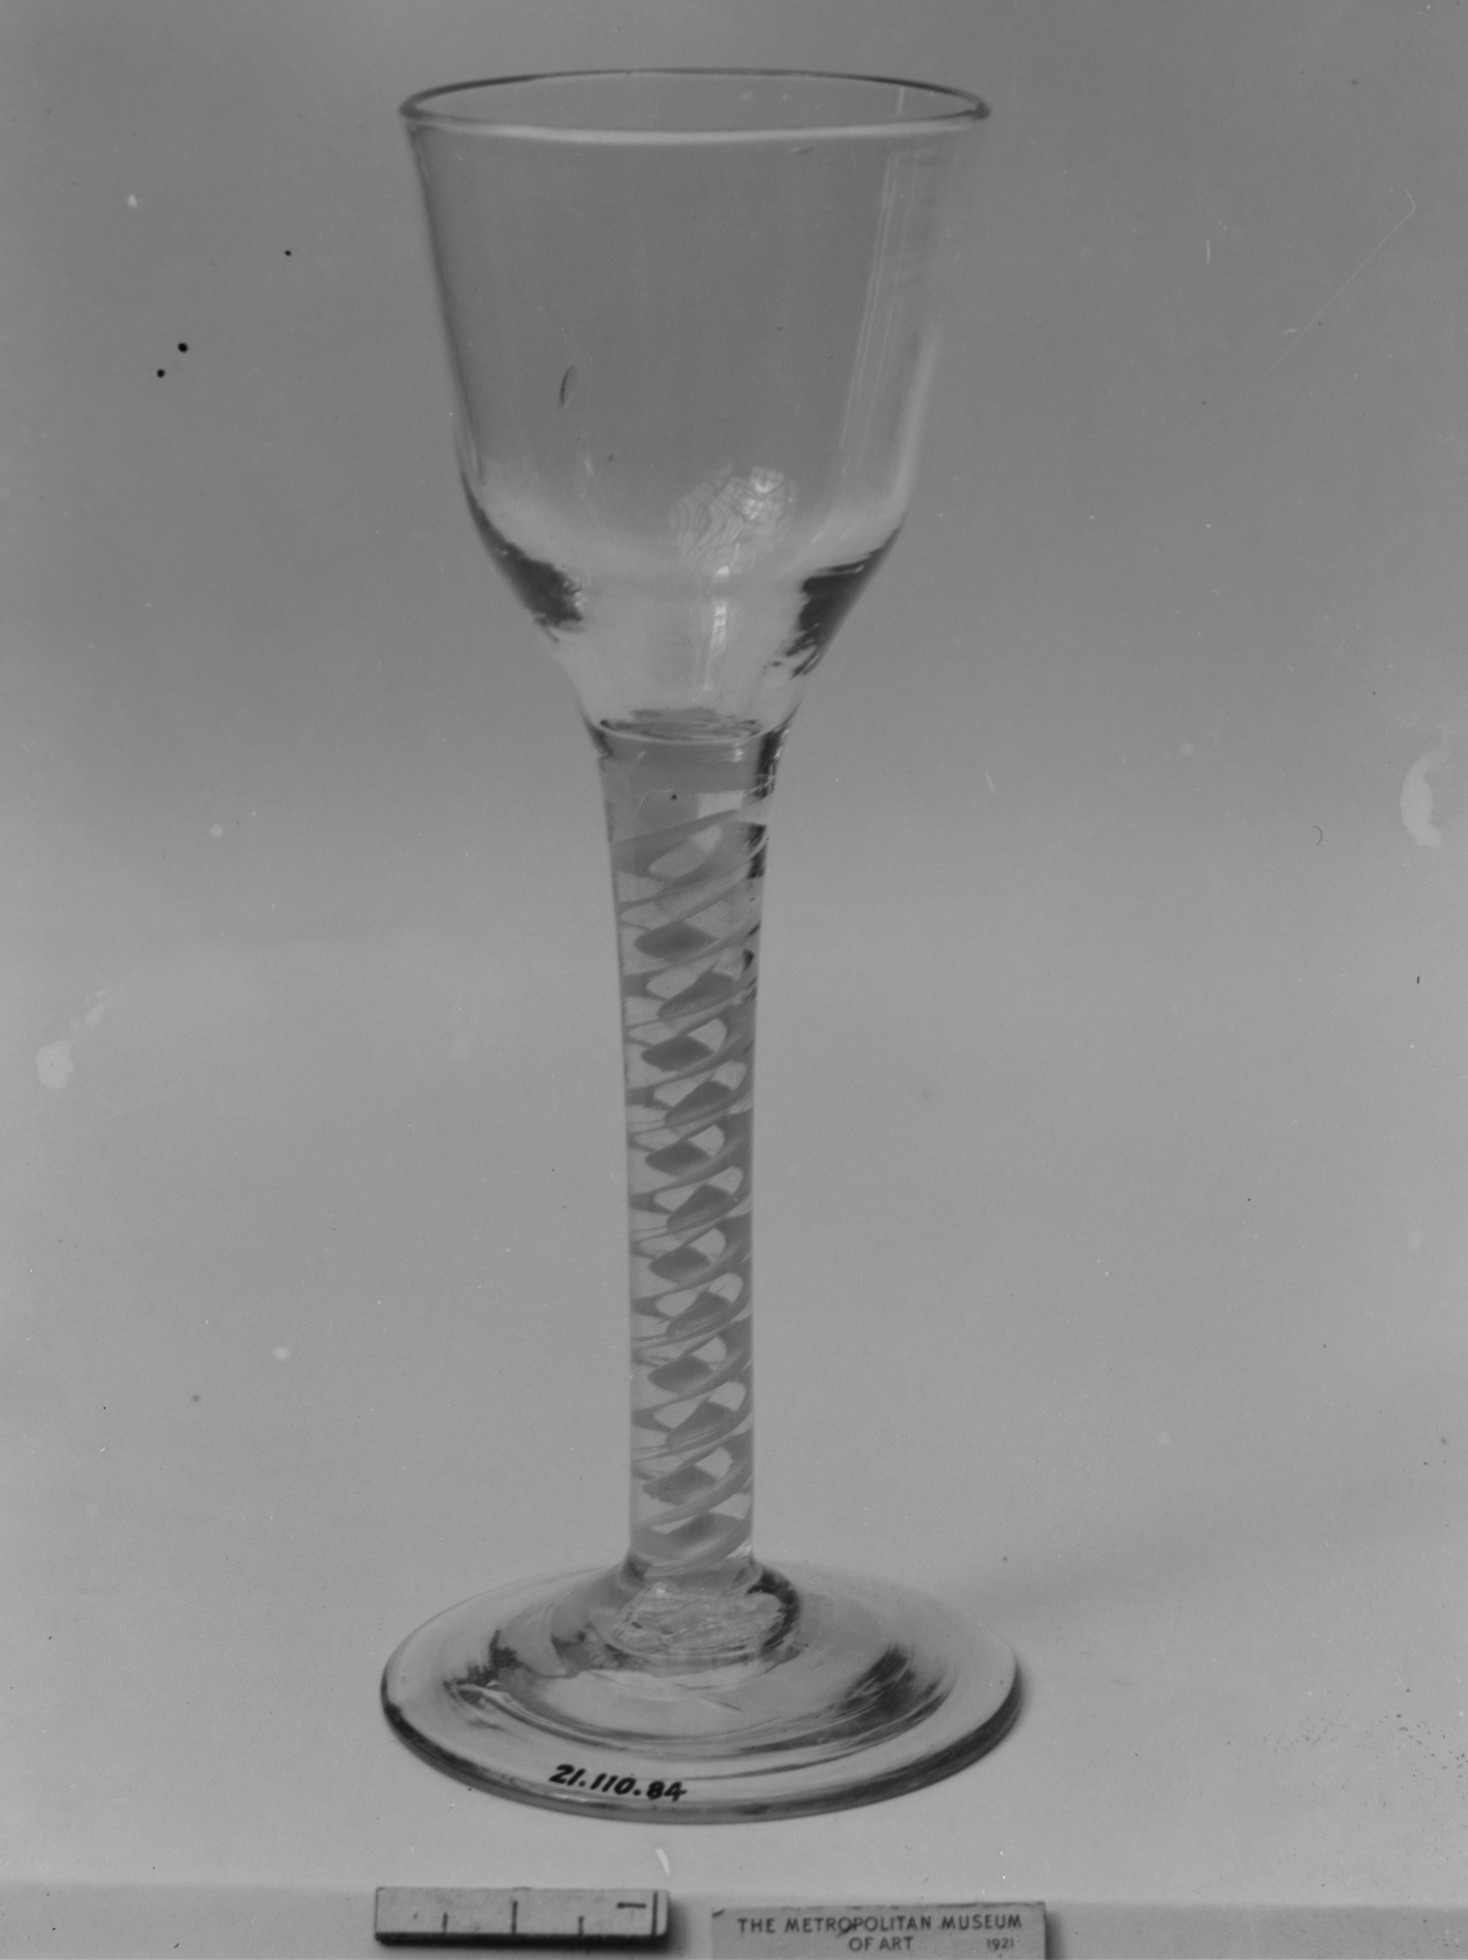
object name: wineglass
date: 1750-1800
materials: glass